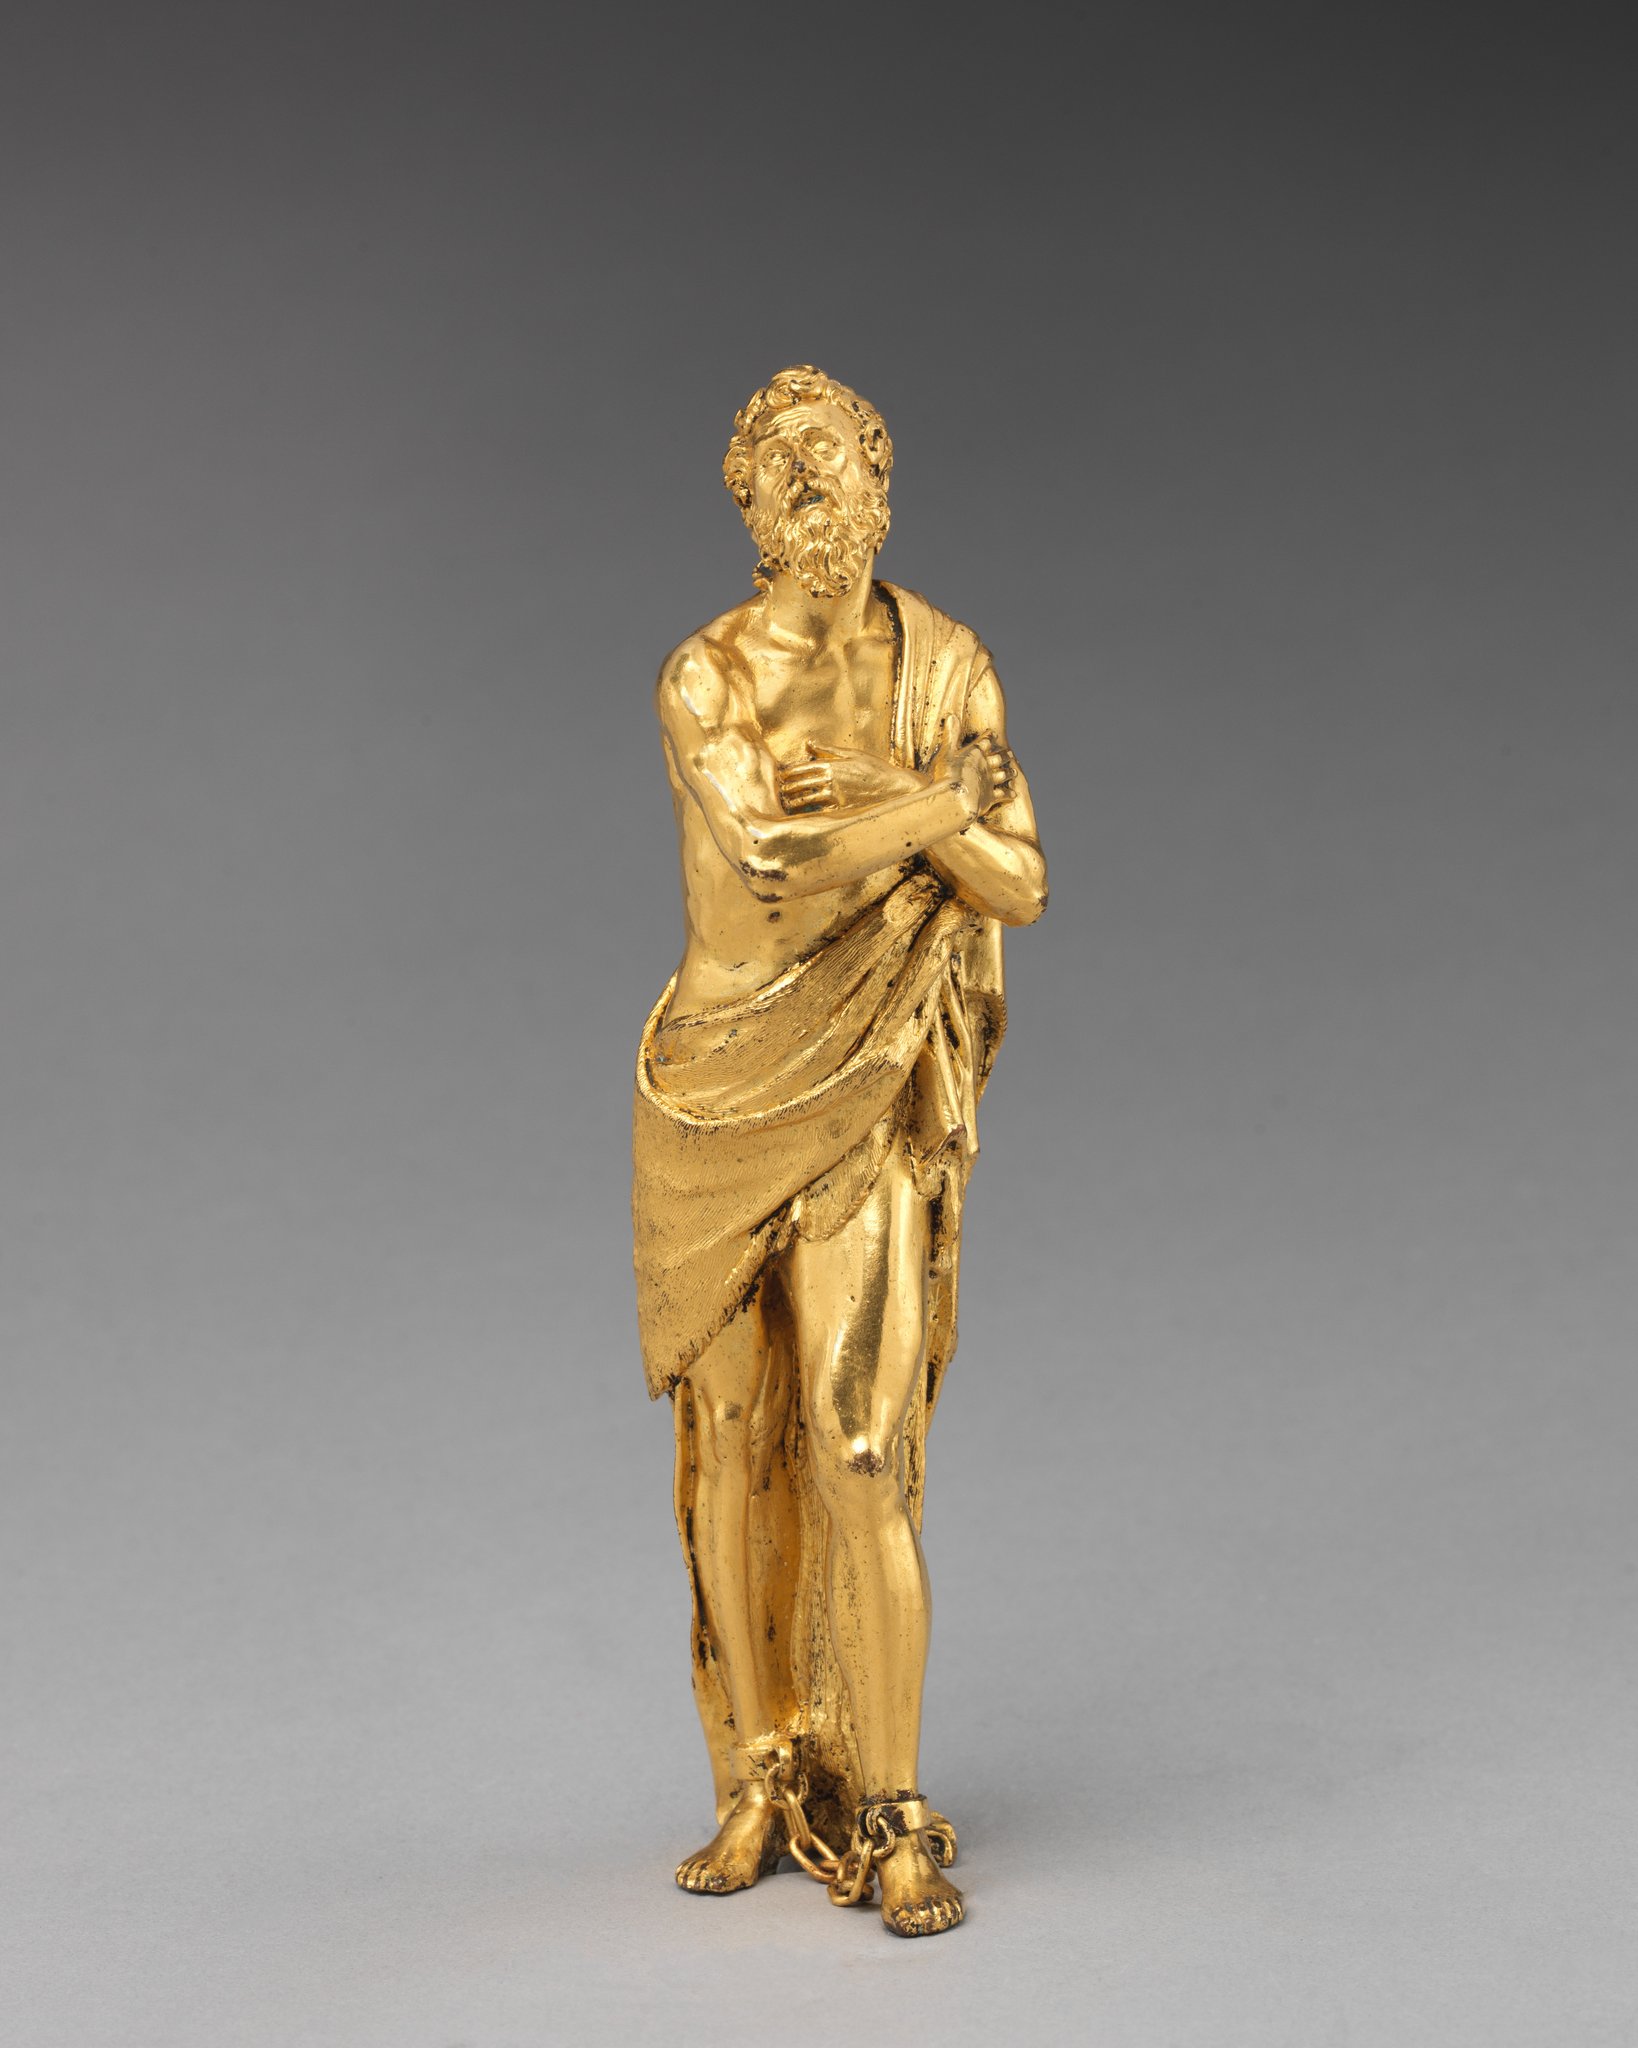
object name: statuette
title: Prisoner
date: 1567-1633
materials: bronze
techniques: gilding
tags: prisoners,men